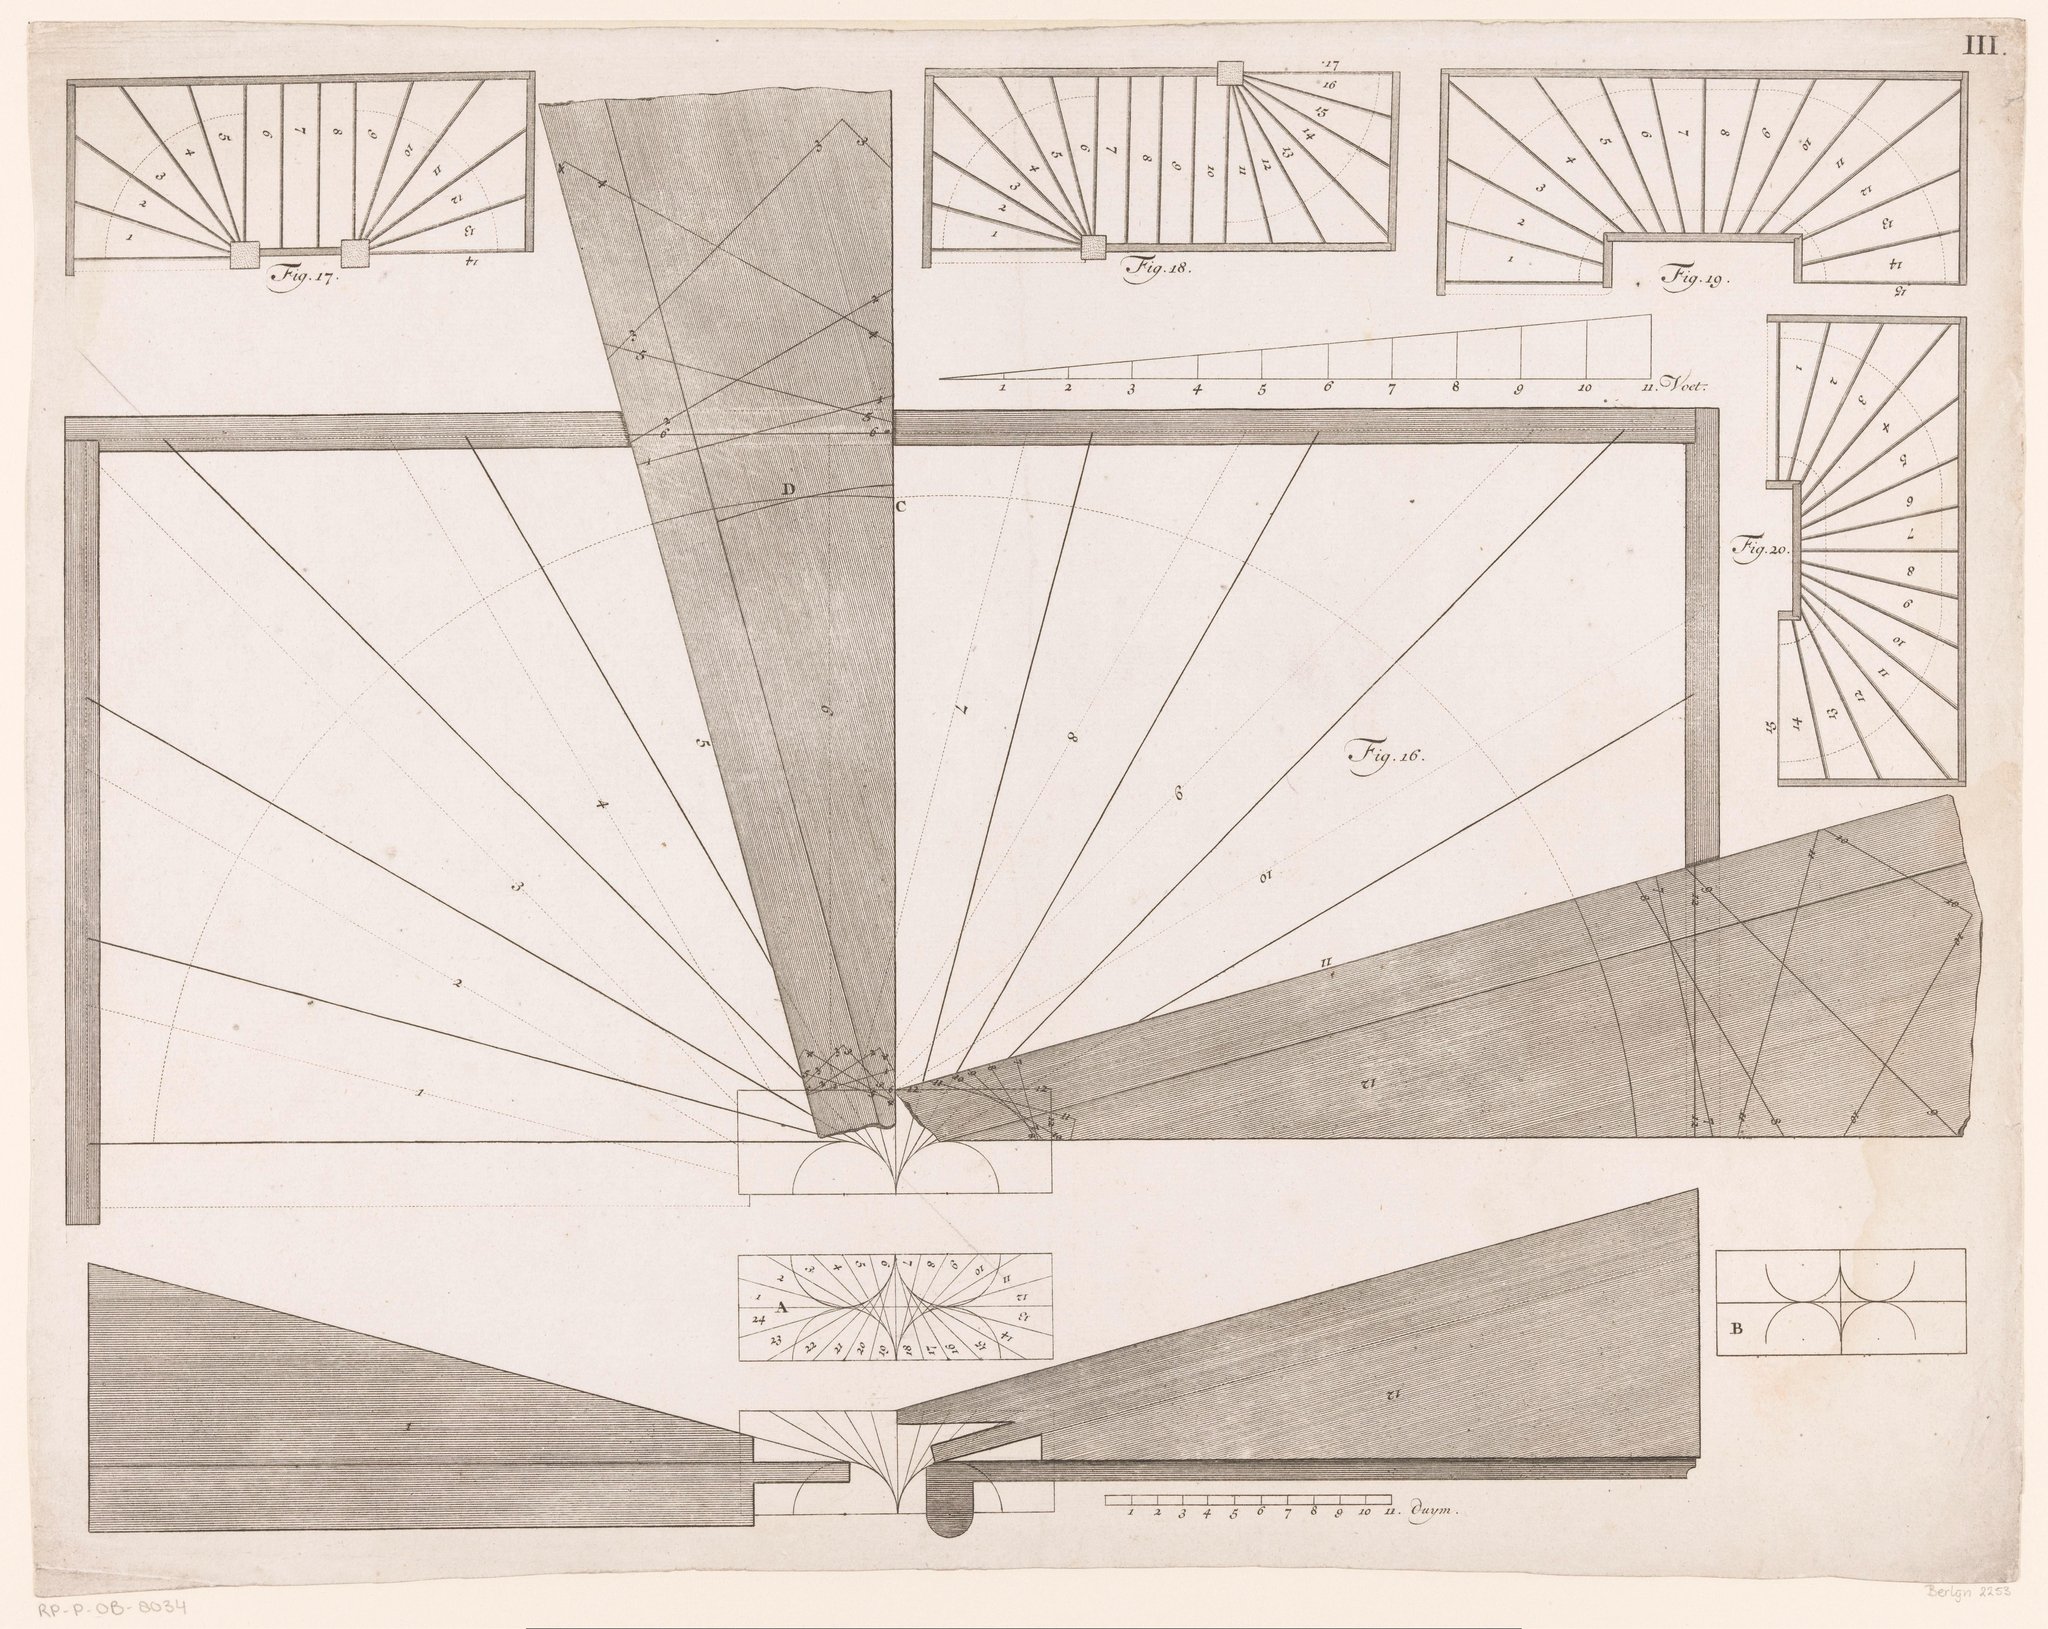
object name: ornament print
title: Theatrum Machinarum Universale; Of Nieuwe Algemeende Bouwkunde (...)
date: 1739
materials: paper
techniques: engraving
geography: amsterdam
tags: drawing (mathematics), staircase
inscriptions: collector's mark: Lugt 2228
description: Technische tekeningen van een spiltrap en trappen met verdreven en onverdreven kwarten (nummers 16 tot en met 20). Bovenaanzichten.